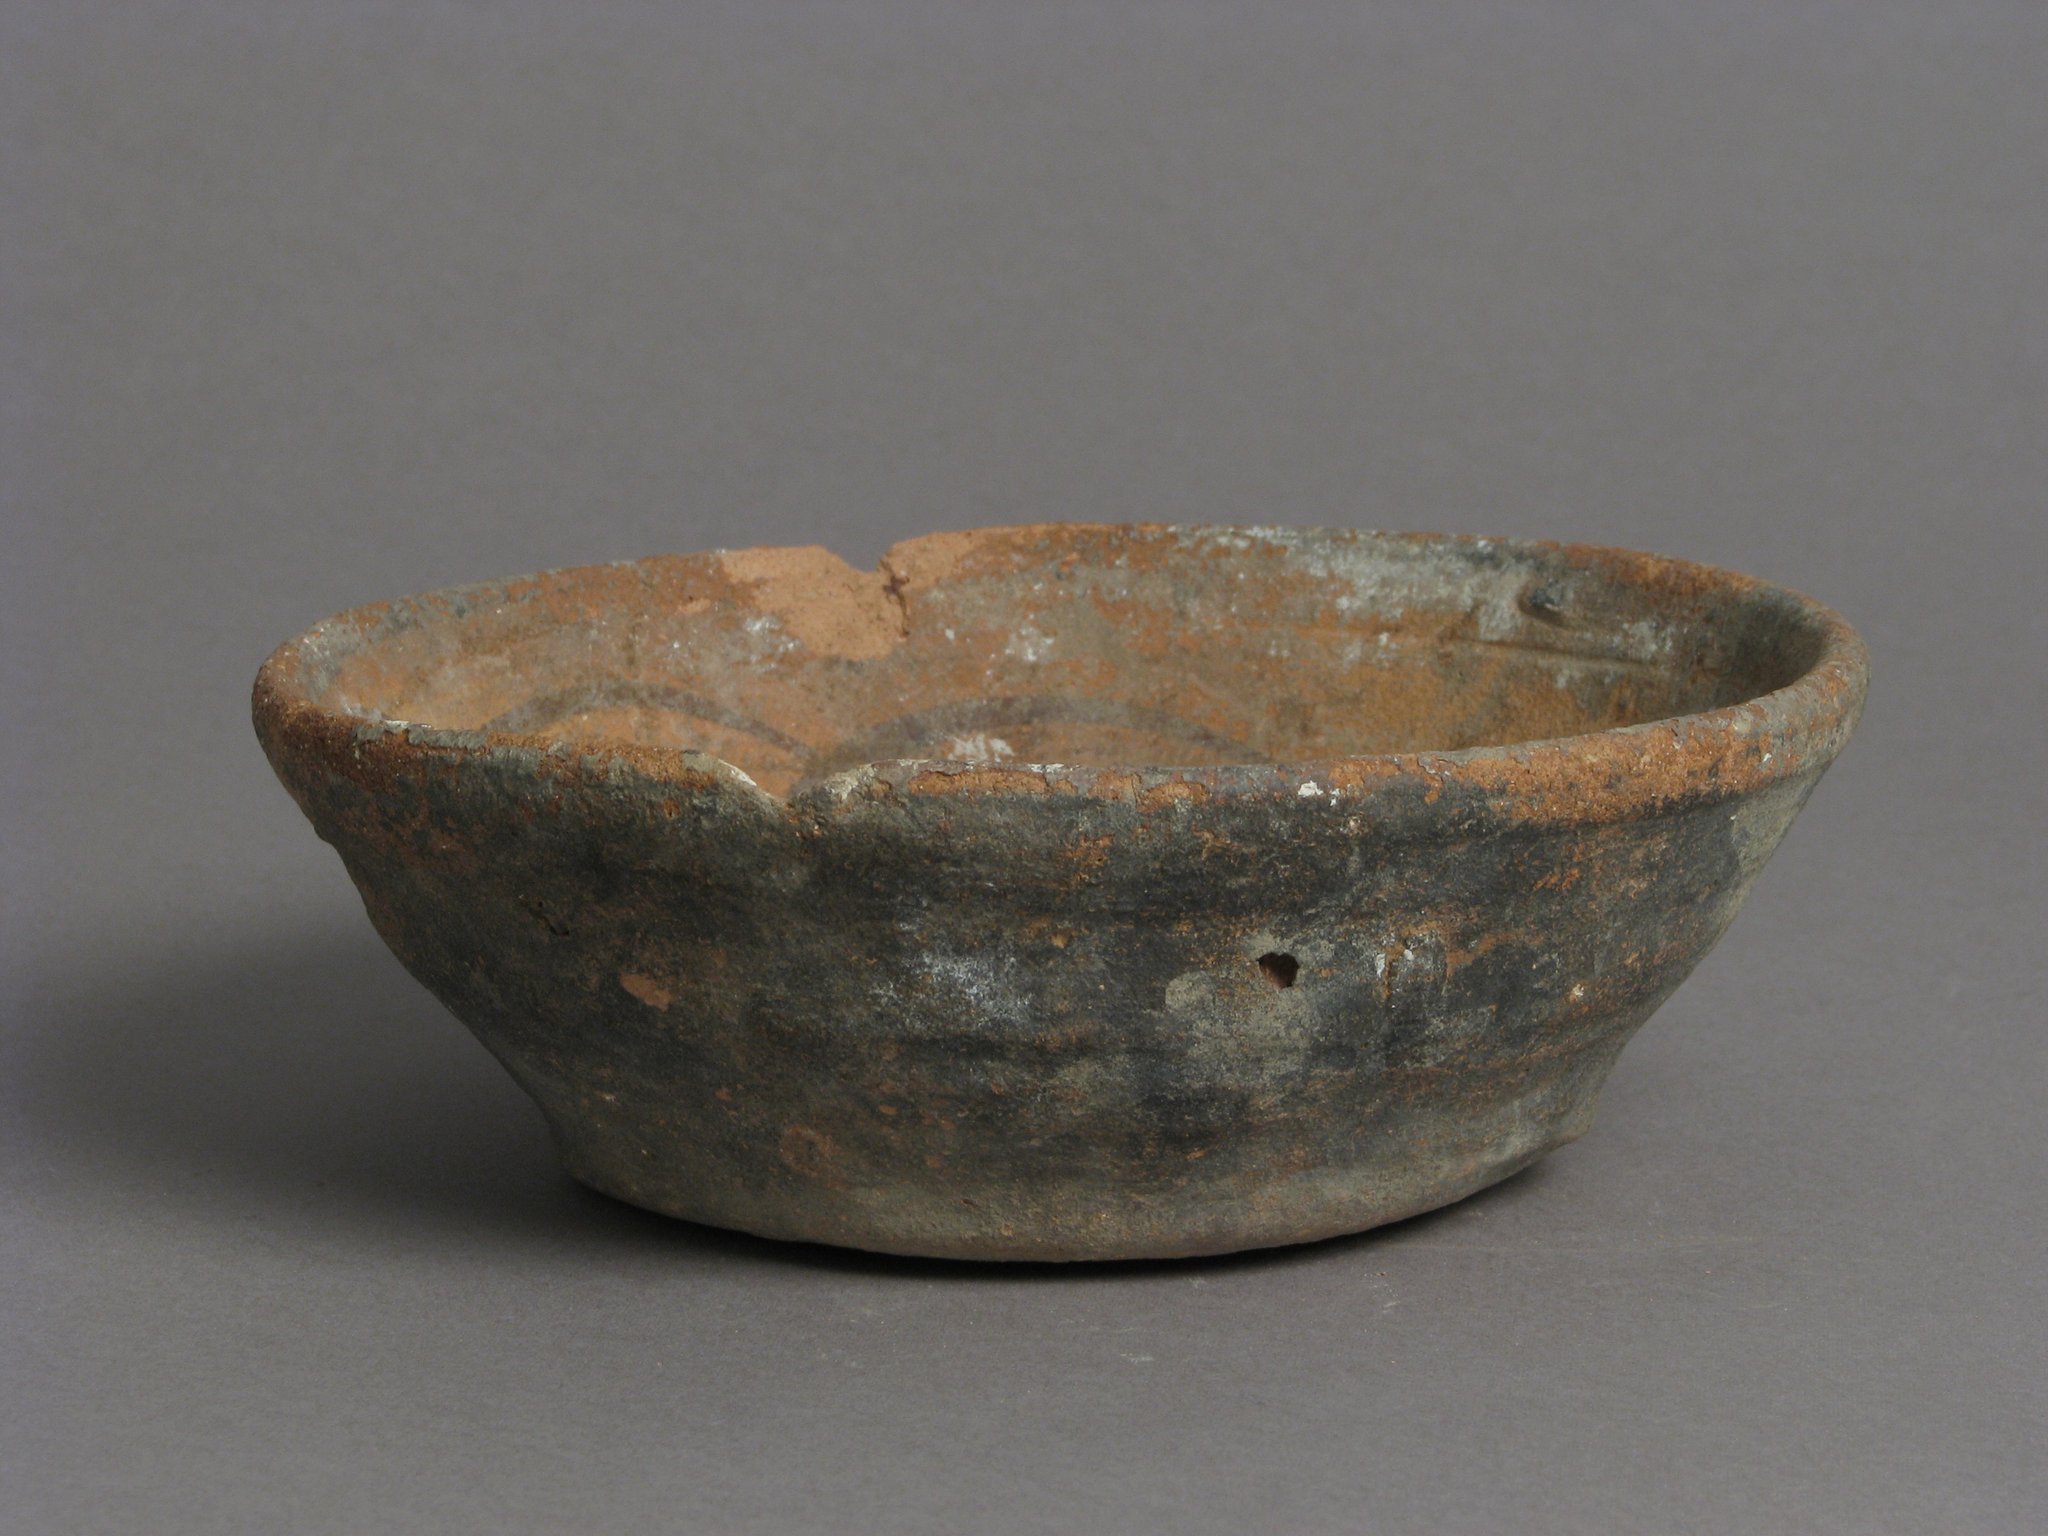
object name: bowl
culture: coptic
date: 301-700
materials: earthenware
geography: egypt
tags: bowls